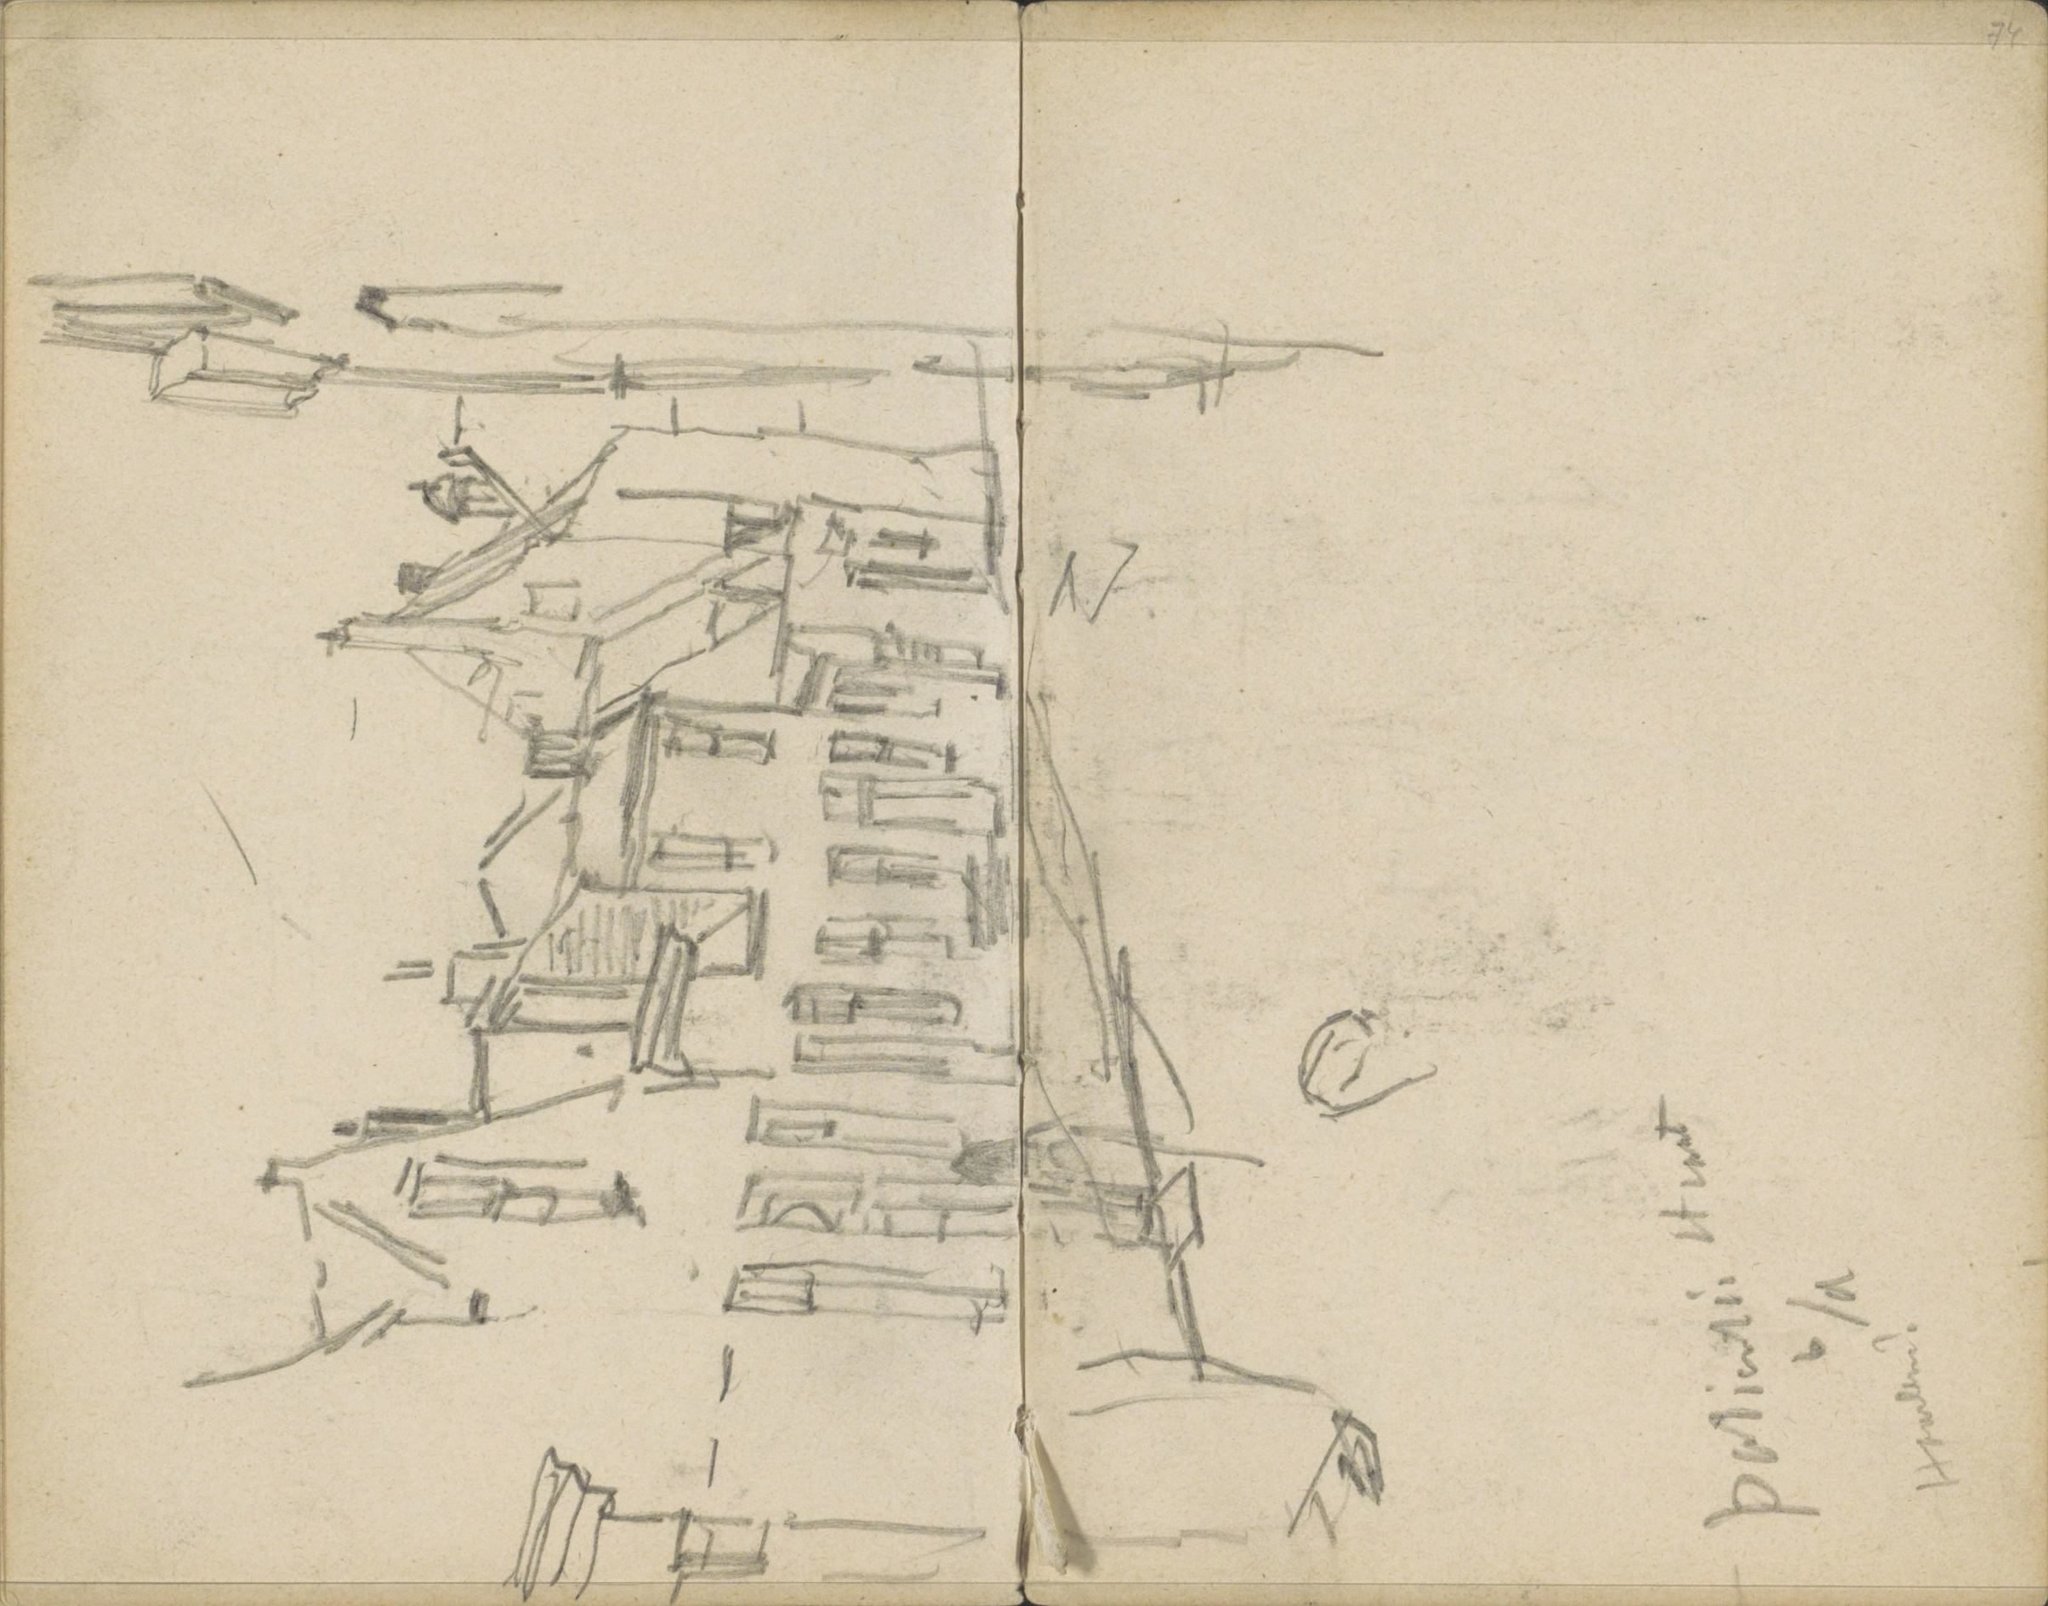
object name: sketchbook leaf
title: Gezicht op de Patiëntiestraat te Haarlem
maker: george hendrik breitner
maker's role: draughtsman, painter, print maker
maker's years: 1857-1923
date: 1902-1914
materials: paper, pencil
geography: haarlem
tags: urban housing, street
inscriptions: annotation: ‘Patientiestraat/ b/d Haarlem?’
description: Gezicht op de Patiëntiestraat te Haarlem. Pagina 73 en pagina 74 uit een schetsboek met 46 bladen vervaardigd te Noord-Holland en Utrecht.